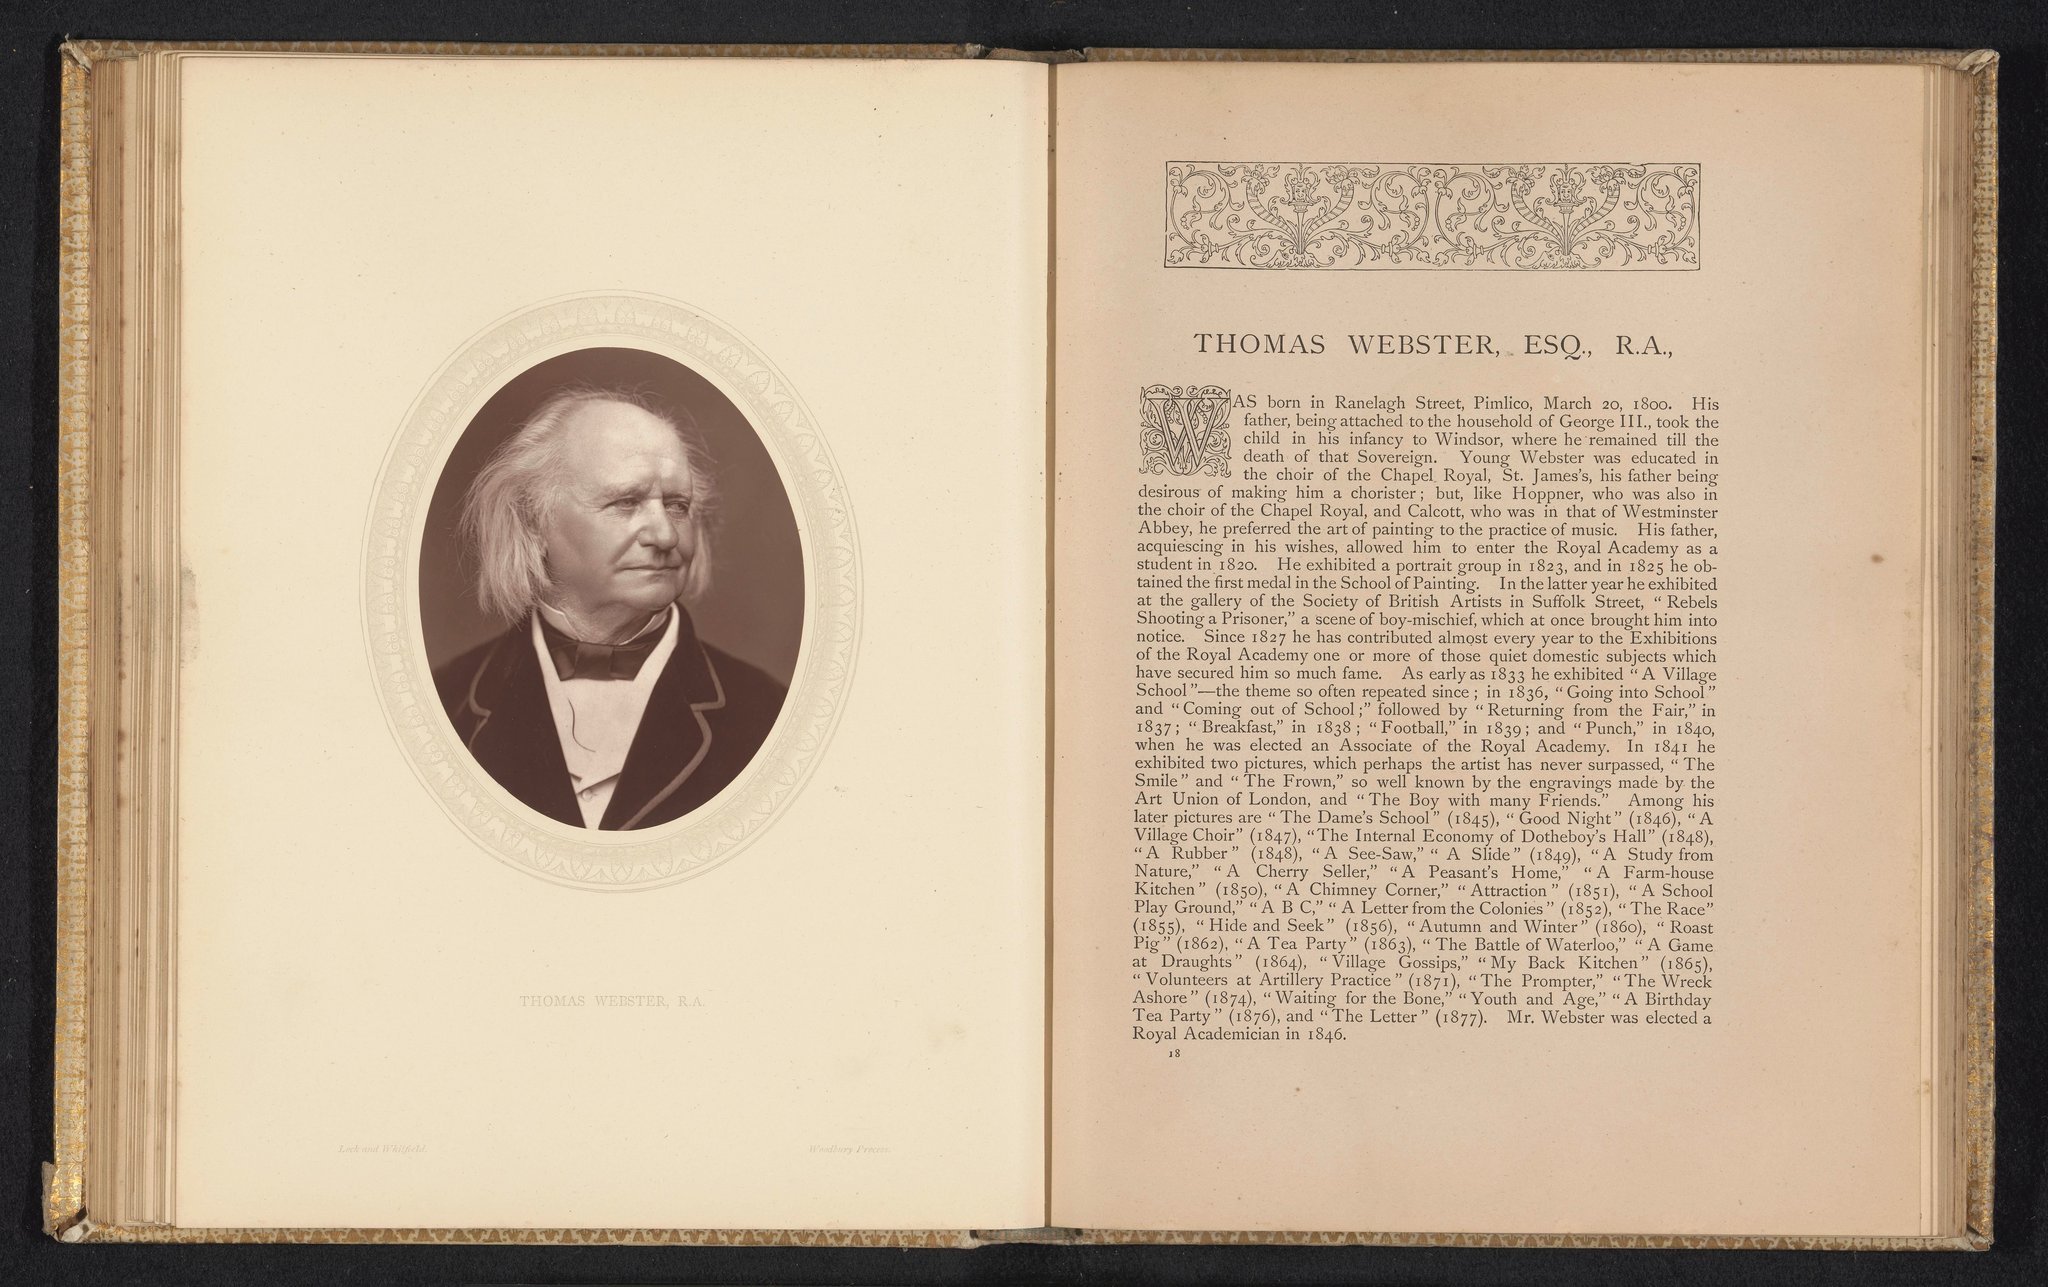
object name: photomechanical print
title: Thomas Webster, R.A.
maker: Anonymous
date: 1873-1878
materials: paper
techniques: woodburytype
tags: portrait, self-portrait of painter, historical persons (portraits and scenes from the life) (+ (full) bust portrait)